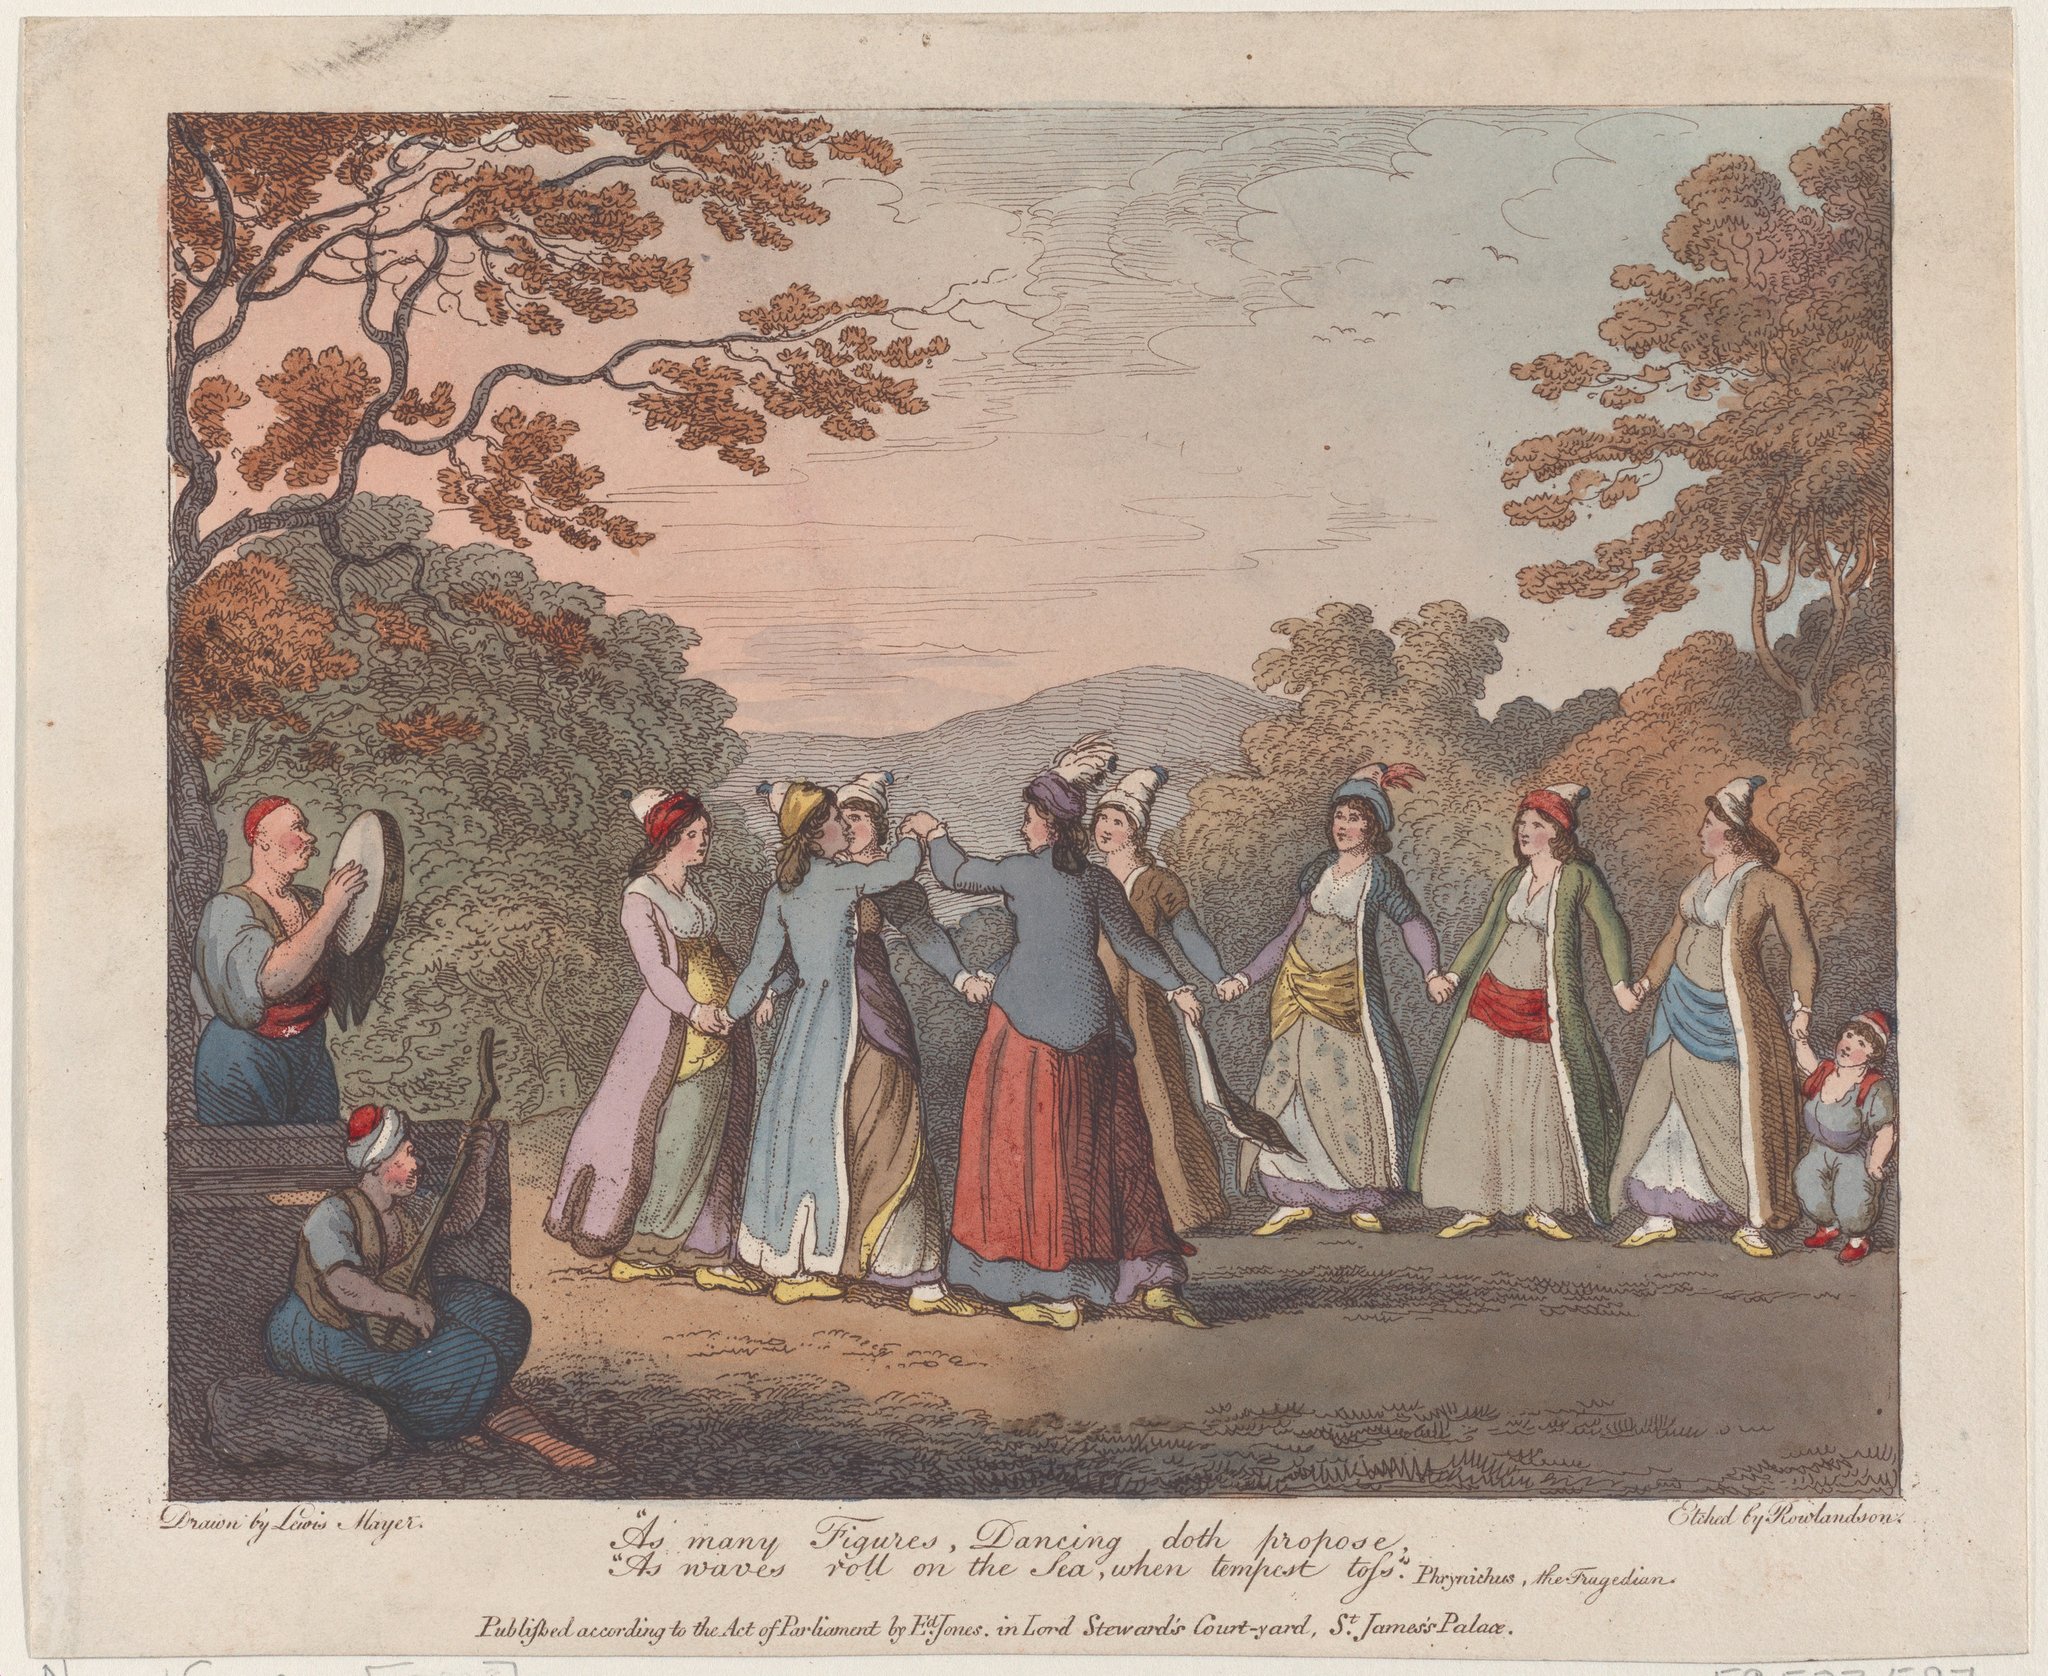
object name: print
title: As many Figures, Dancing doth propose, As waves roll on the Sea, when tempest toss (Phrynichus, the Tragedian)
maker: thomas rowlandson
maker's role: artist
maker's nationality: british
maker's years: 1757-1827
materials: ink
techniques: etching, printing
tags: men,women,dancing,musicians